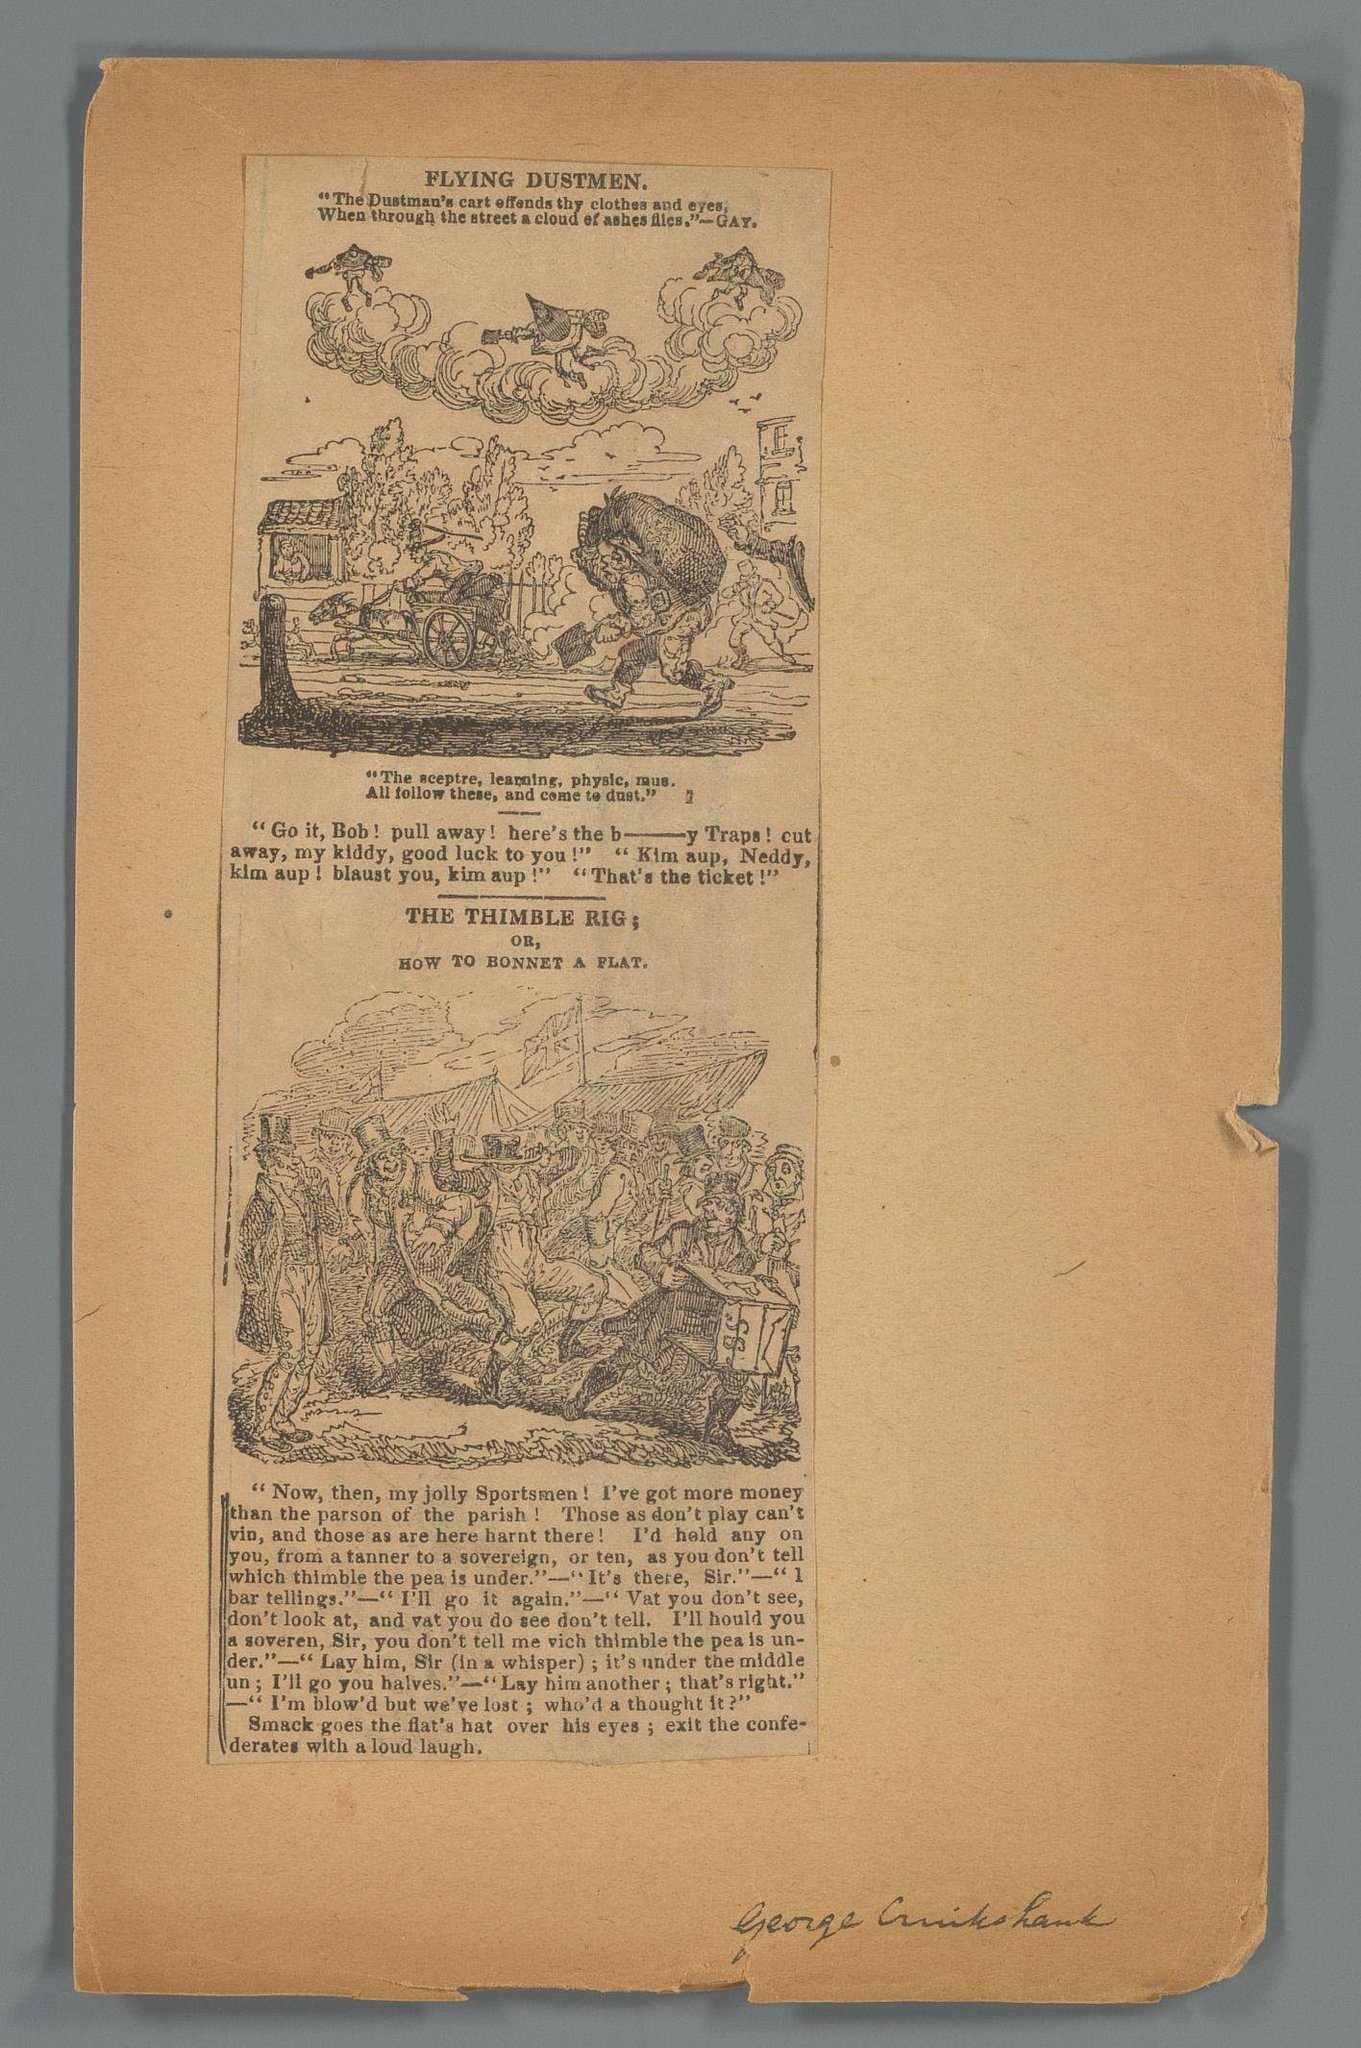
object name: cartoon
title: Twee voorstellingen uit: The gallery of 140 comicalities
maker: Anonymous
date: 1831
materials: paper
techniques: engraving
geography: england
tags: man dancing alone, garbage collection, political caricatures and satires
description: Voorstellingen geknipt uit de bladen van: The gallery of 140 comicalities, Which has appeared from time to time, in that most Popular Sporting Sunday Paper, "Bell's Life in London", Printed and Published by George Goodger, 169, Strand, London June 24, 1831.